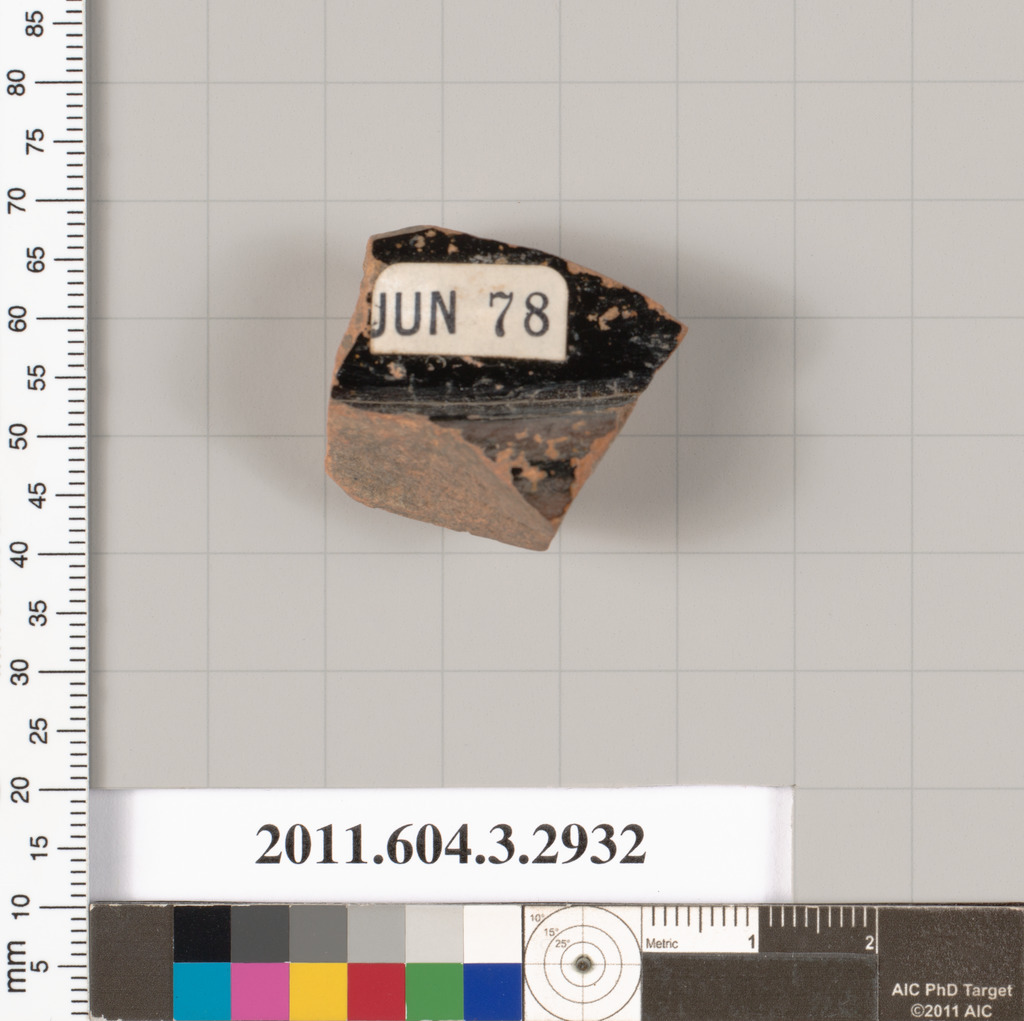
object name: undetermined closed shape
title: Terracotta fragment of a closed shape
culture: greek, attic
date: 600-401 BCE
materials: terracotta